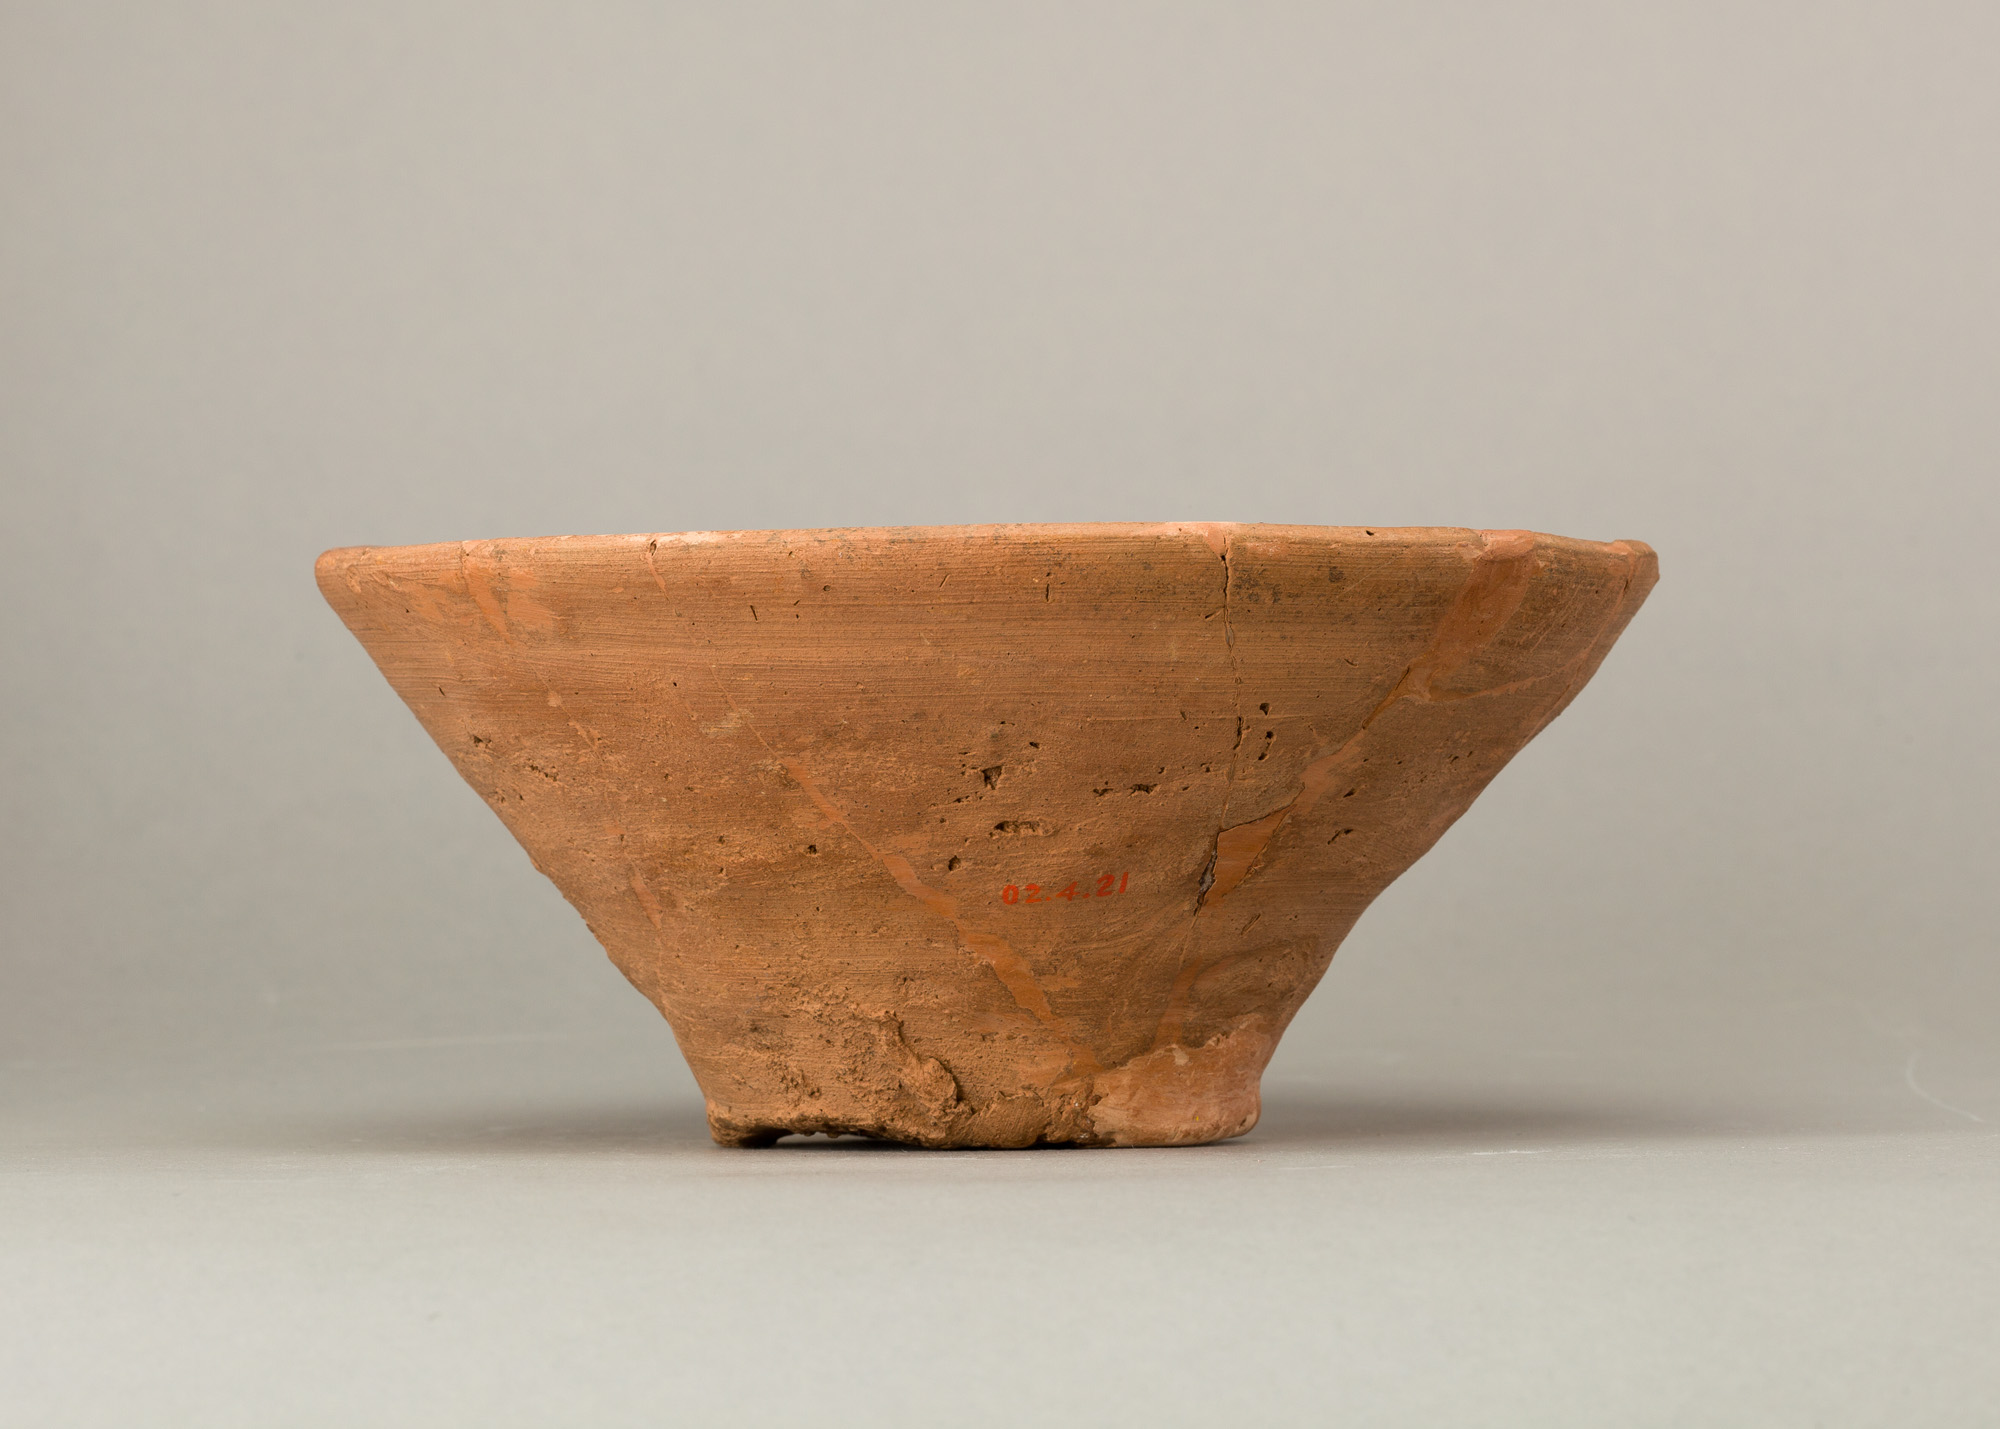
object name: bowl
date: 2960-2770 BCE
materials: pottery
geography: egypt